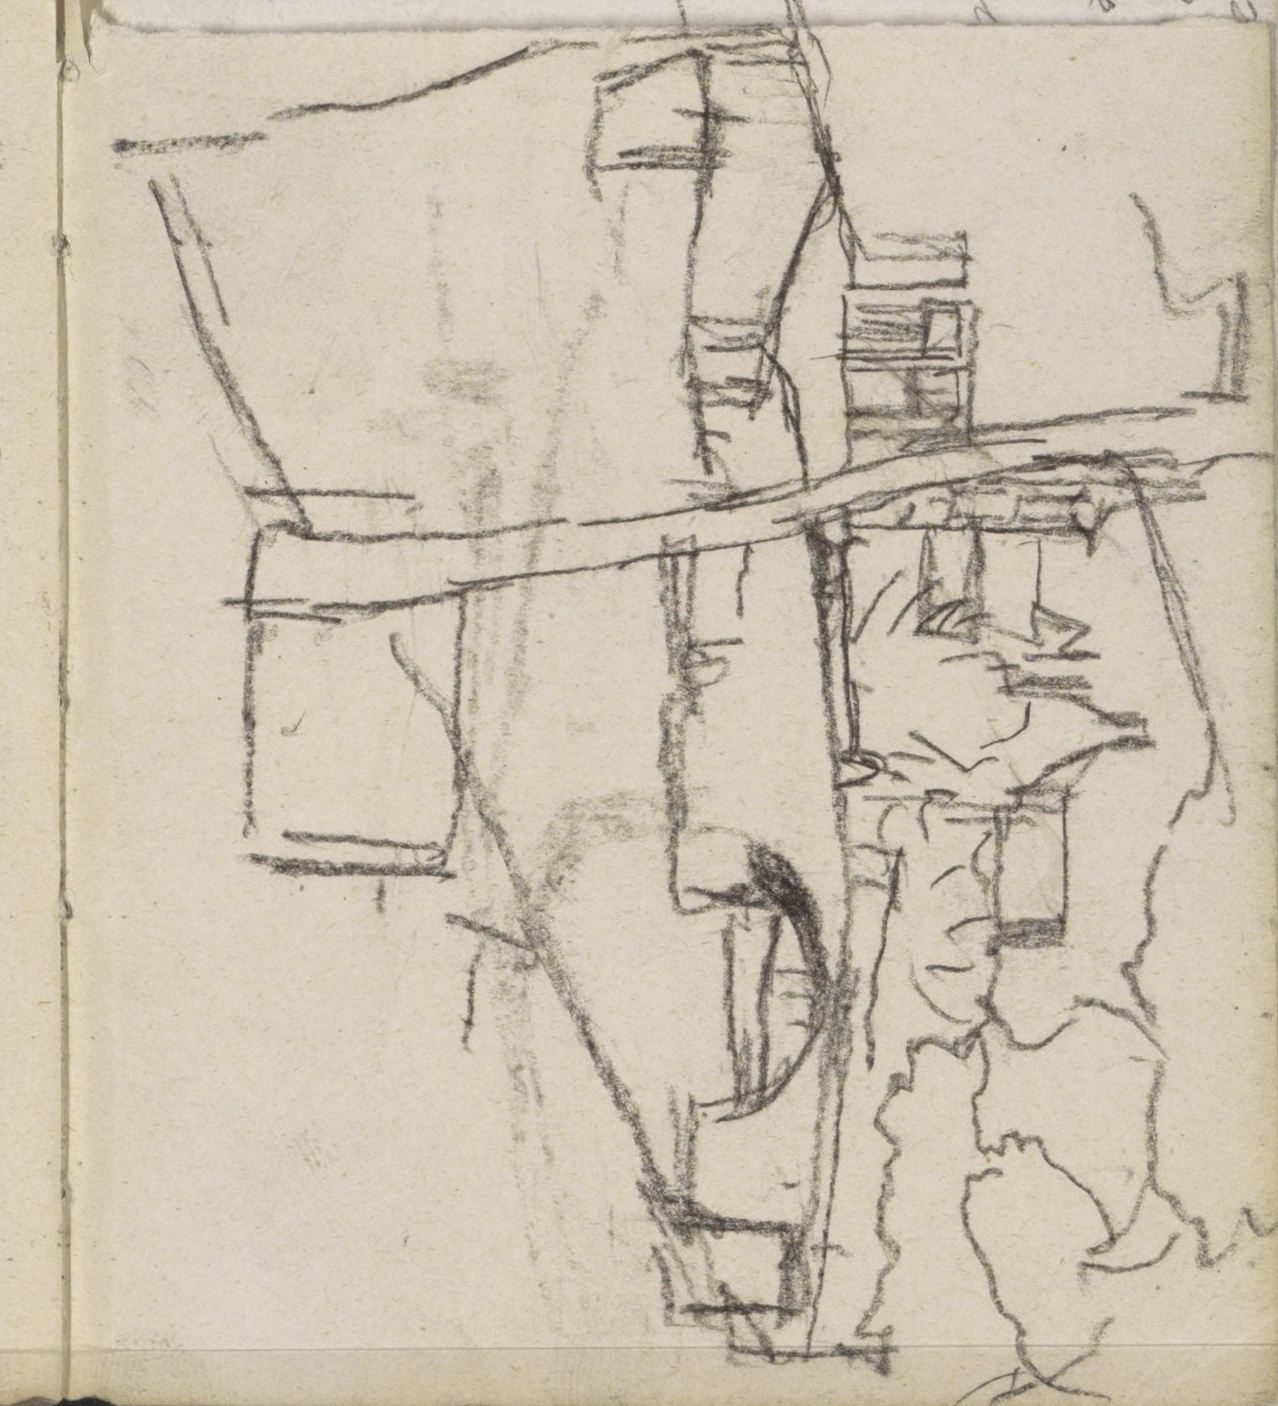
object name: sketchbook leaf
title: Gezicht op een brug over een gracht te Amsterdam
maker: george hendrik breitner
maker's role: draughtsman, painter, print maker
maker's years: 1857-1923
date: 1907-1909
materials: chalk, paper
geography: amsterdam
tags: bridge in city across river, canal, etc., amsterdam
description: Gezicht op een brug over een gracht te Amsterdam. Pagina 90 uit een schetsboek met 46 bladen vervaardigd te Antwerpen, Gent en Amsterdam.